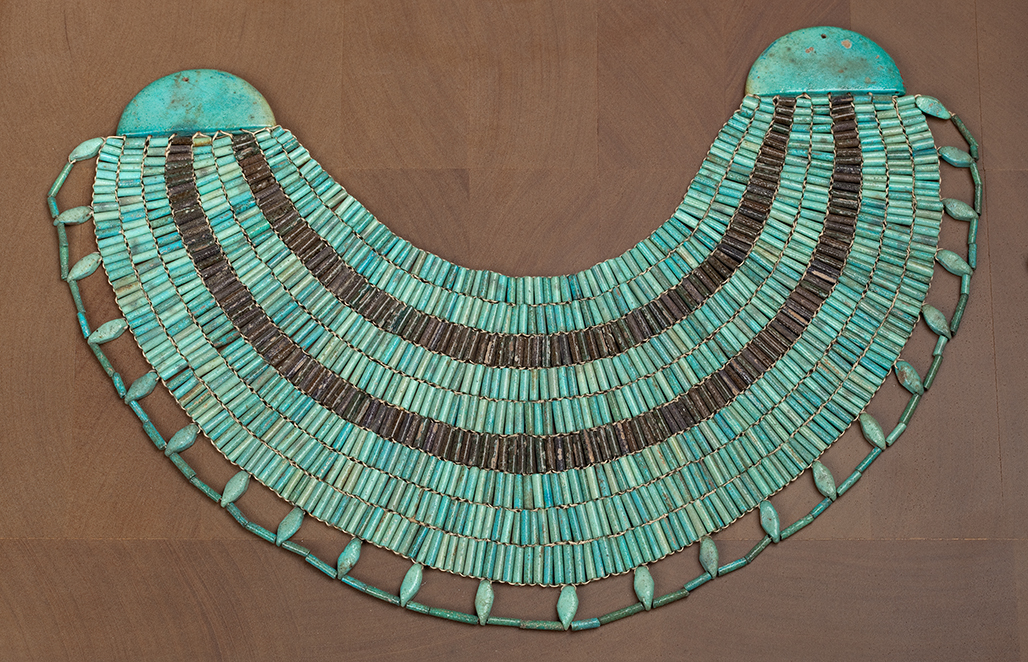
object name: broad collar, hapiankhtifi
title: Model Broad Collar of Hapiankhtifi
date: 1981-1802 BCE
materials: faience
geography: egypt